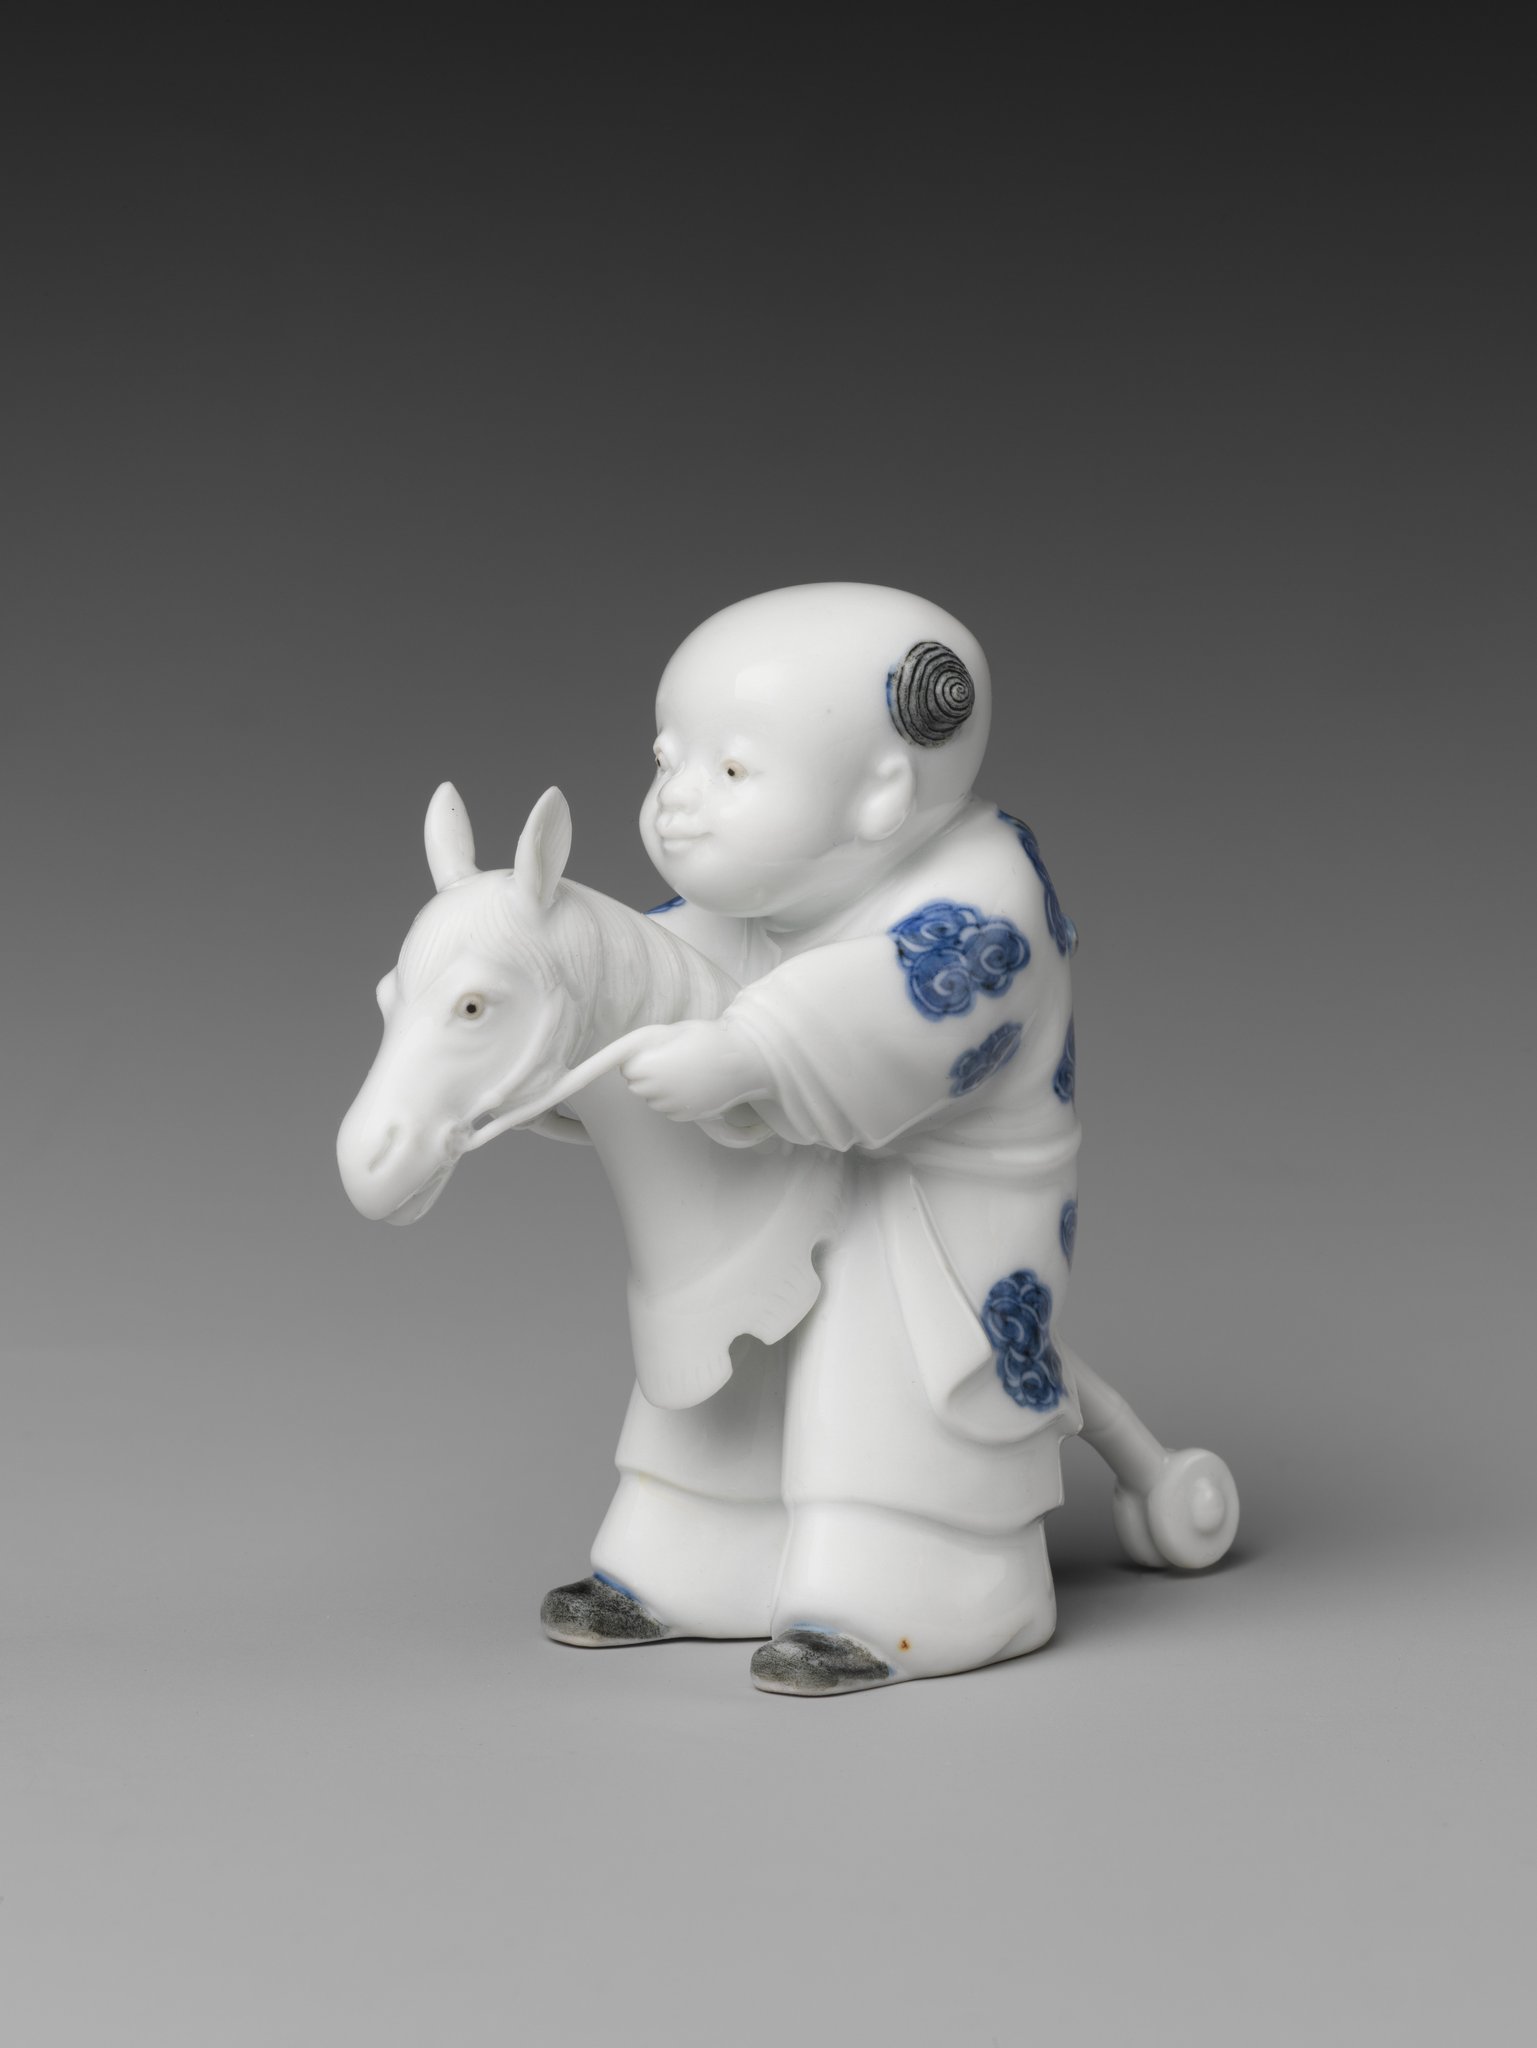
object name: ornament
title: Chinese Child on a Hobby Horse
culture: japanese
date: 1767-1800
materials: porcelain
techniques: underglaze